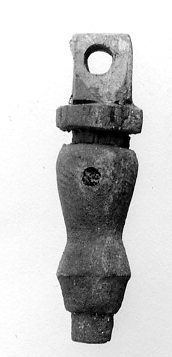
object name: model, bed, leg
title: Leg of a Model Bed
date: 1550-1295 BCE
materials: wood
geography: egypt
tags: furniture